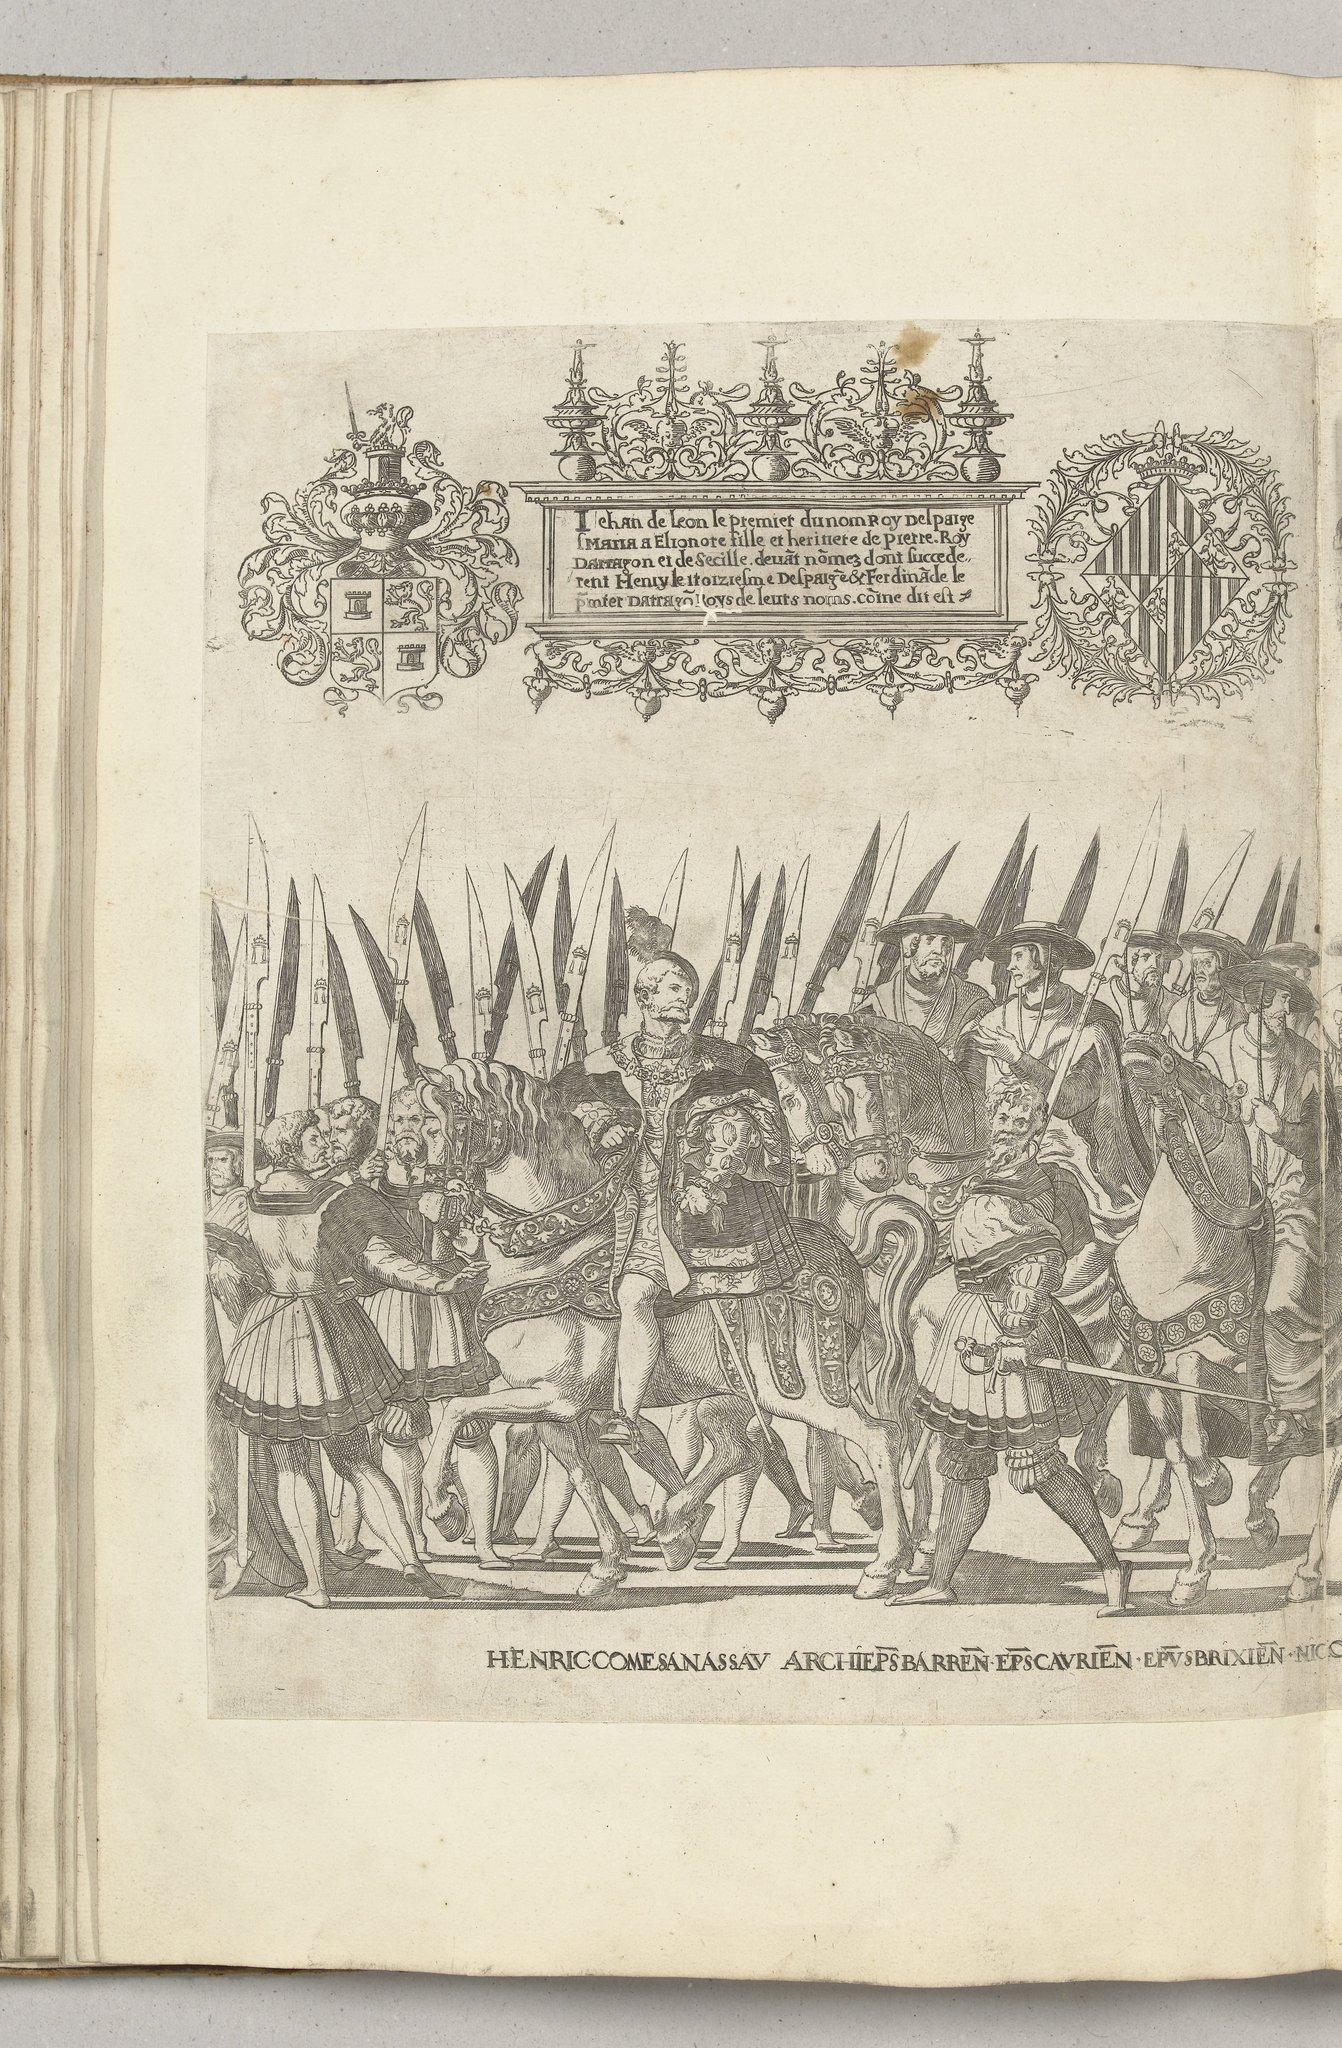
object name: propagandaprent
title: Optocht van Karel V met de paus te Bologna na zijn kroning to keizer, 1530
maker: nicolaas hogenberg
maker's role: draughtsman, painter, print maker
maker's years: 1500-1539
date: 1530-1536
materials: paper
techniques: etching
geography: mechelen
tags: earl, ghent, charles v (holy roman emperor and king of spain), festivities (+ parade, pageant, cavalcade ~ festive activities)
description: Hendrik III van Nassau-Breda, aartsbisschop van Bari en de bisschoppen van Coria, Palecia, Osma, Arras en Brixen, plaat [FF]. Optocht van Karel V met de paus Clemens VII te Bologna na zijn kroning to keizer, 24 februari 1530.